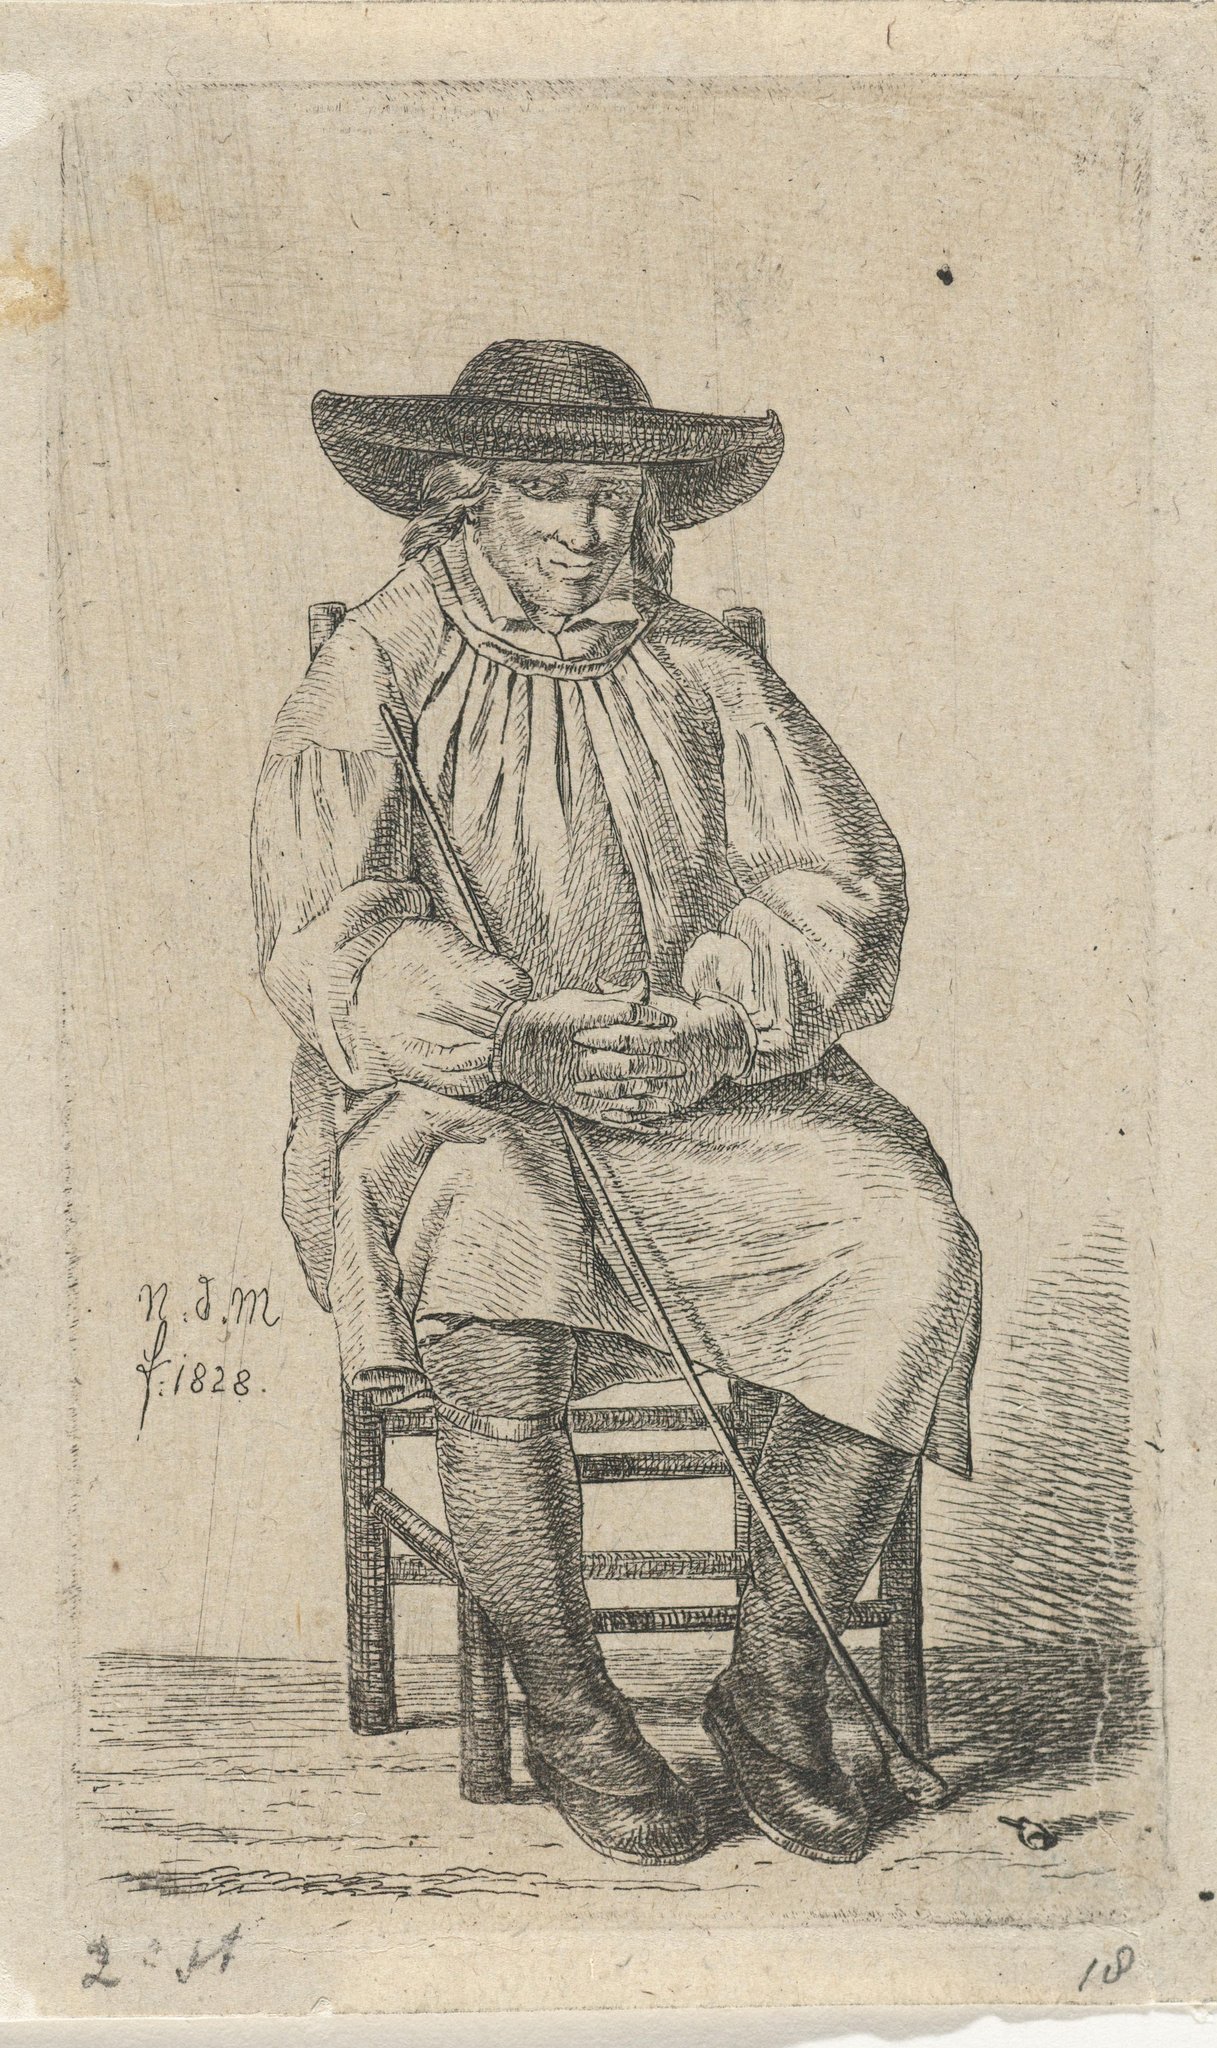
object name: print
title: 12 Studie-beeldjes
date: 1828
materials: paper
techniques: etching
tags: sitting figure, chair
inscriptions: collector's mark: Lugt 2227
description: Zittende man met stok, voor hem op de grond een klein pijpenkopje. Prent uit een serie van twaalf prenten met studies van menselijke figuren.